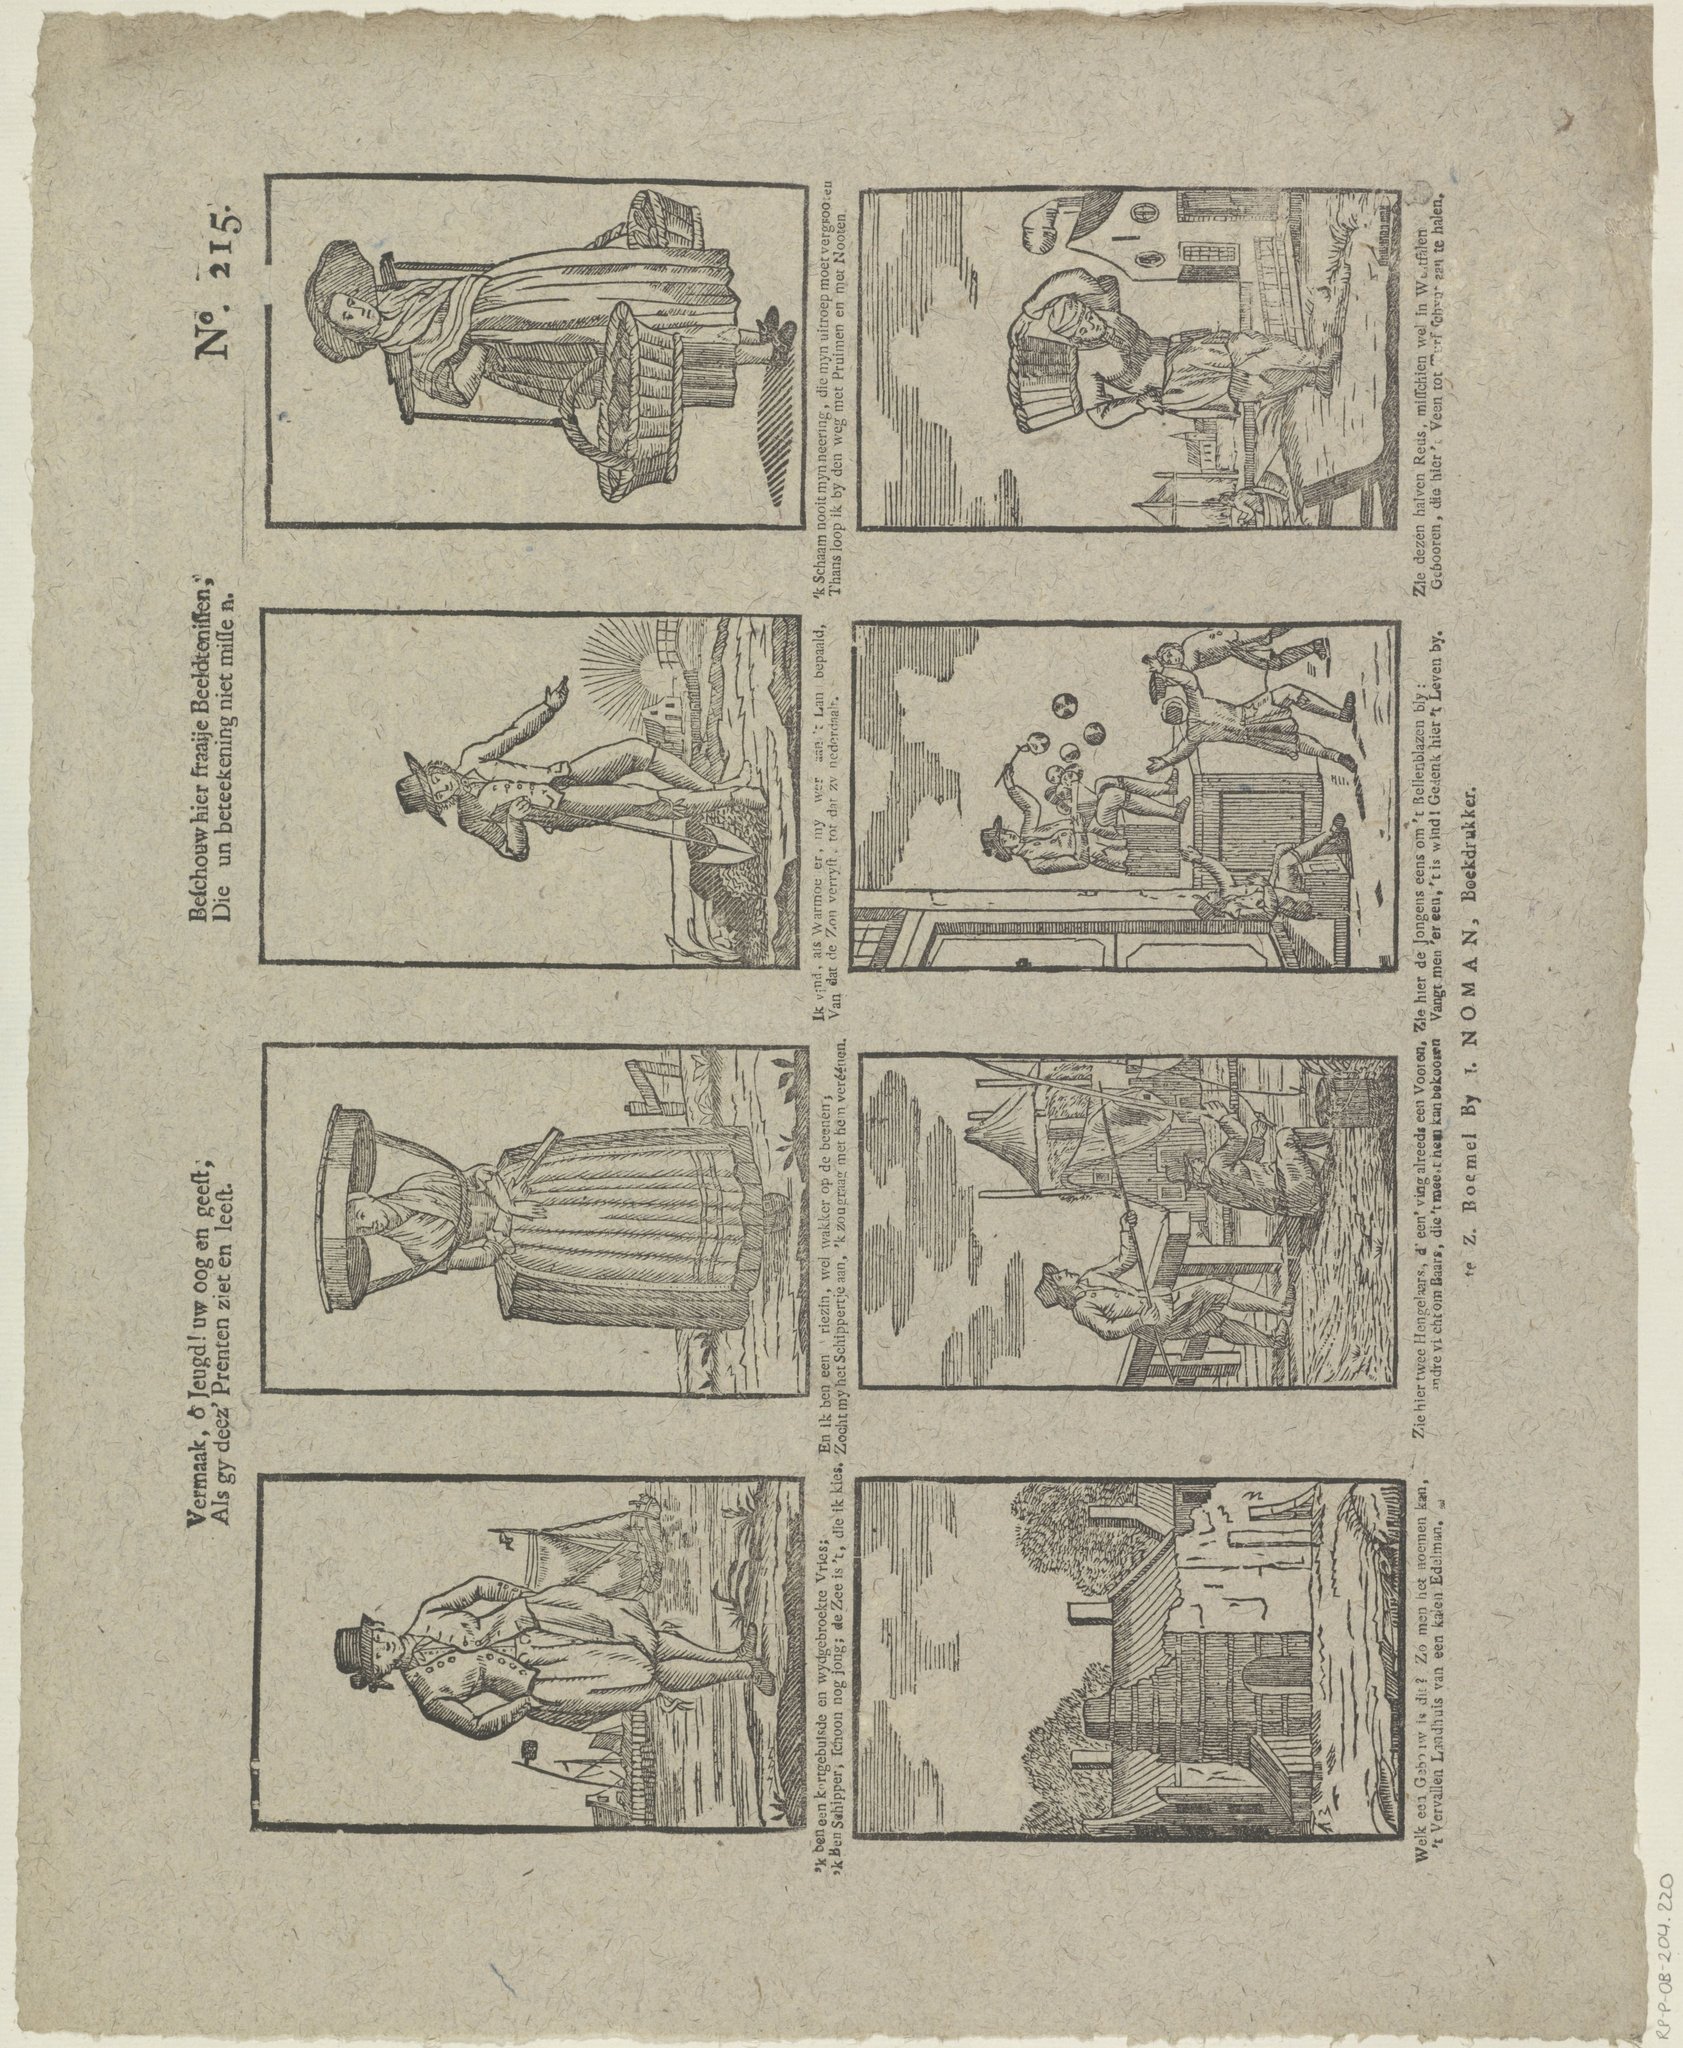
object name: popular print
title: Vermaak, ô jeugd! uw oog en geeft, / Als gy deez' prenten ziet en leest. / Beschouw hier fraaije beeldtenissen, / Die un beteekening niet missen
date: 1806-1830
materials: paper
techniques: letterpress printing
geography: zaltbommel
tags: human types, farmers, street-trader, fisherman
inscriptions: collector's mark: Lugt 2760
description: Blad met 8 voorstellingen van verschillende figuren en beroepen. Onder elke voorstelling een tweeregelig vers. Genummerd rechtsboven: No. 215.